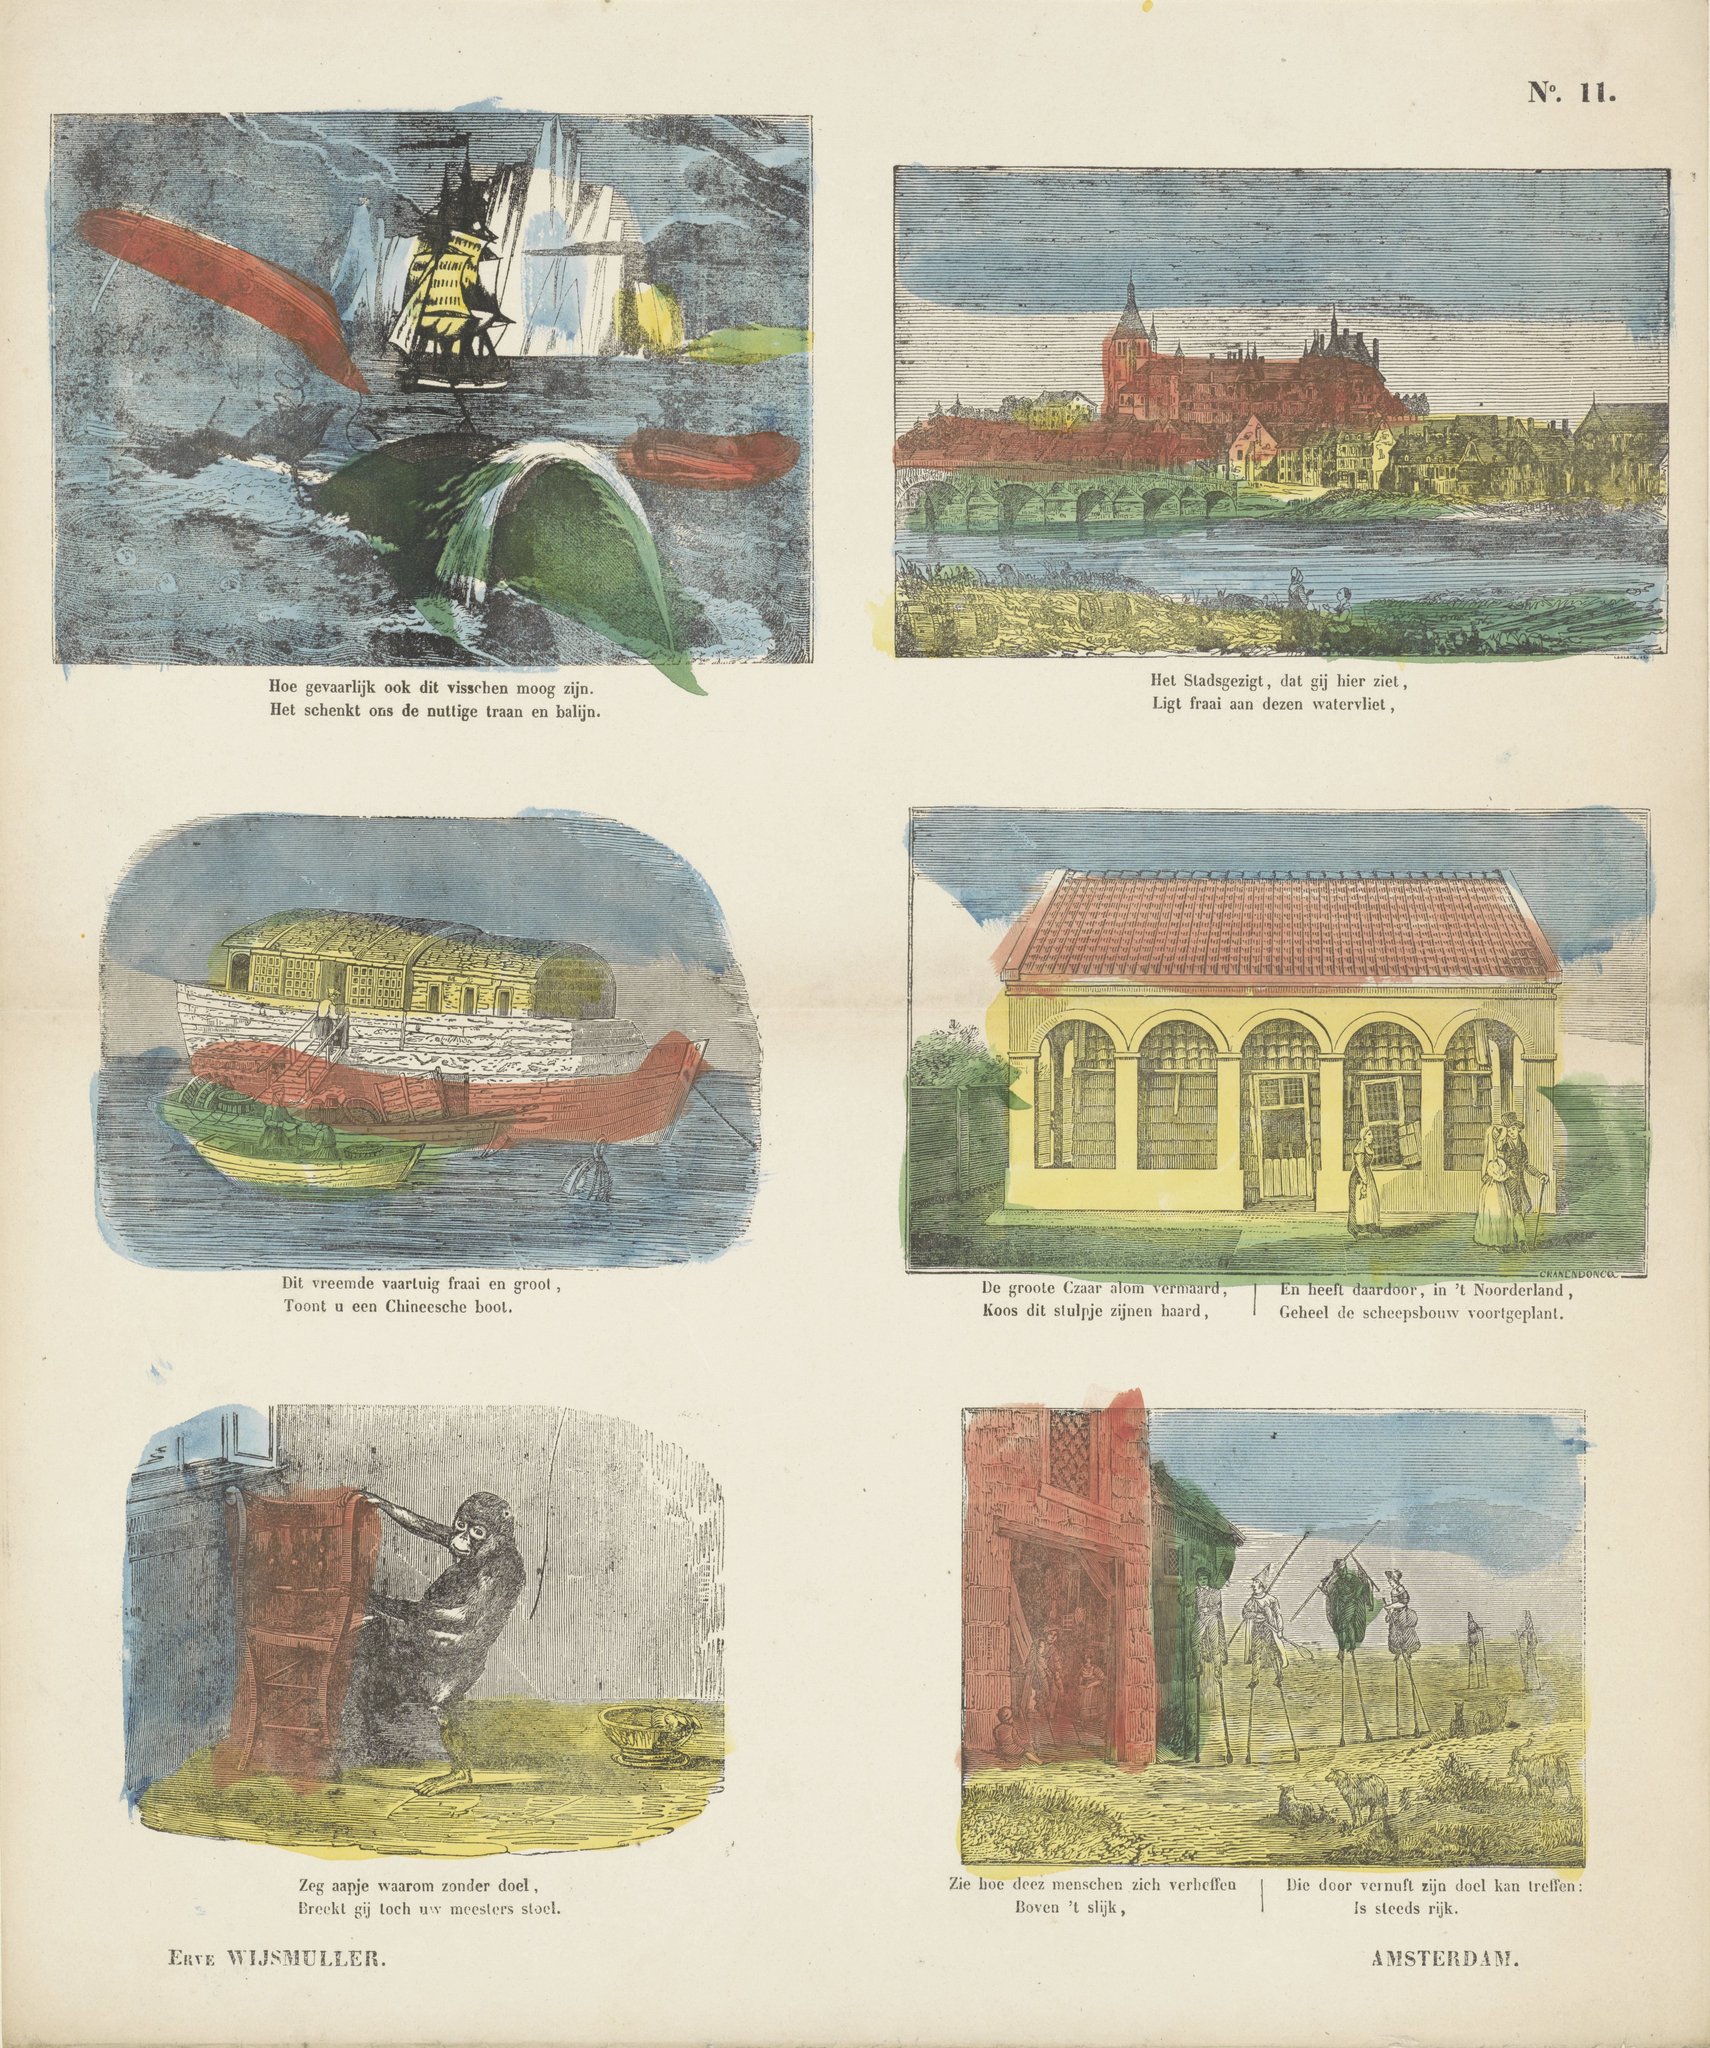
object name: popular print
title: Verschillende voorstellingen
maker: Anonymous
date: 1828-1913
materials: paper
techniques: colour, letterpress printing, line block, engraving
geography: amsterdam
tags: city-view in general; 'veduta', monkeys, apes, housing, whale fishery, whaling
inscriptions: collector's mark: Lugt 2760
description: Blad met 6 voorstellingen van verschillende aard, waaronder landschappen en gebouwen. Onder elke afbeelding een onderschrift. Onder de eerste afbeelding het onderschrift: Hoe gevaarlijk ook dit visschen moog zijn... Genummerd rechtsboven: No. 11.